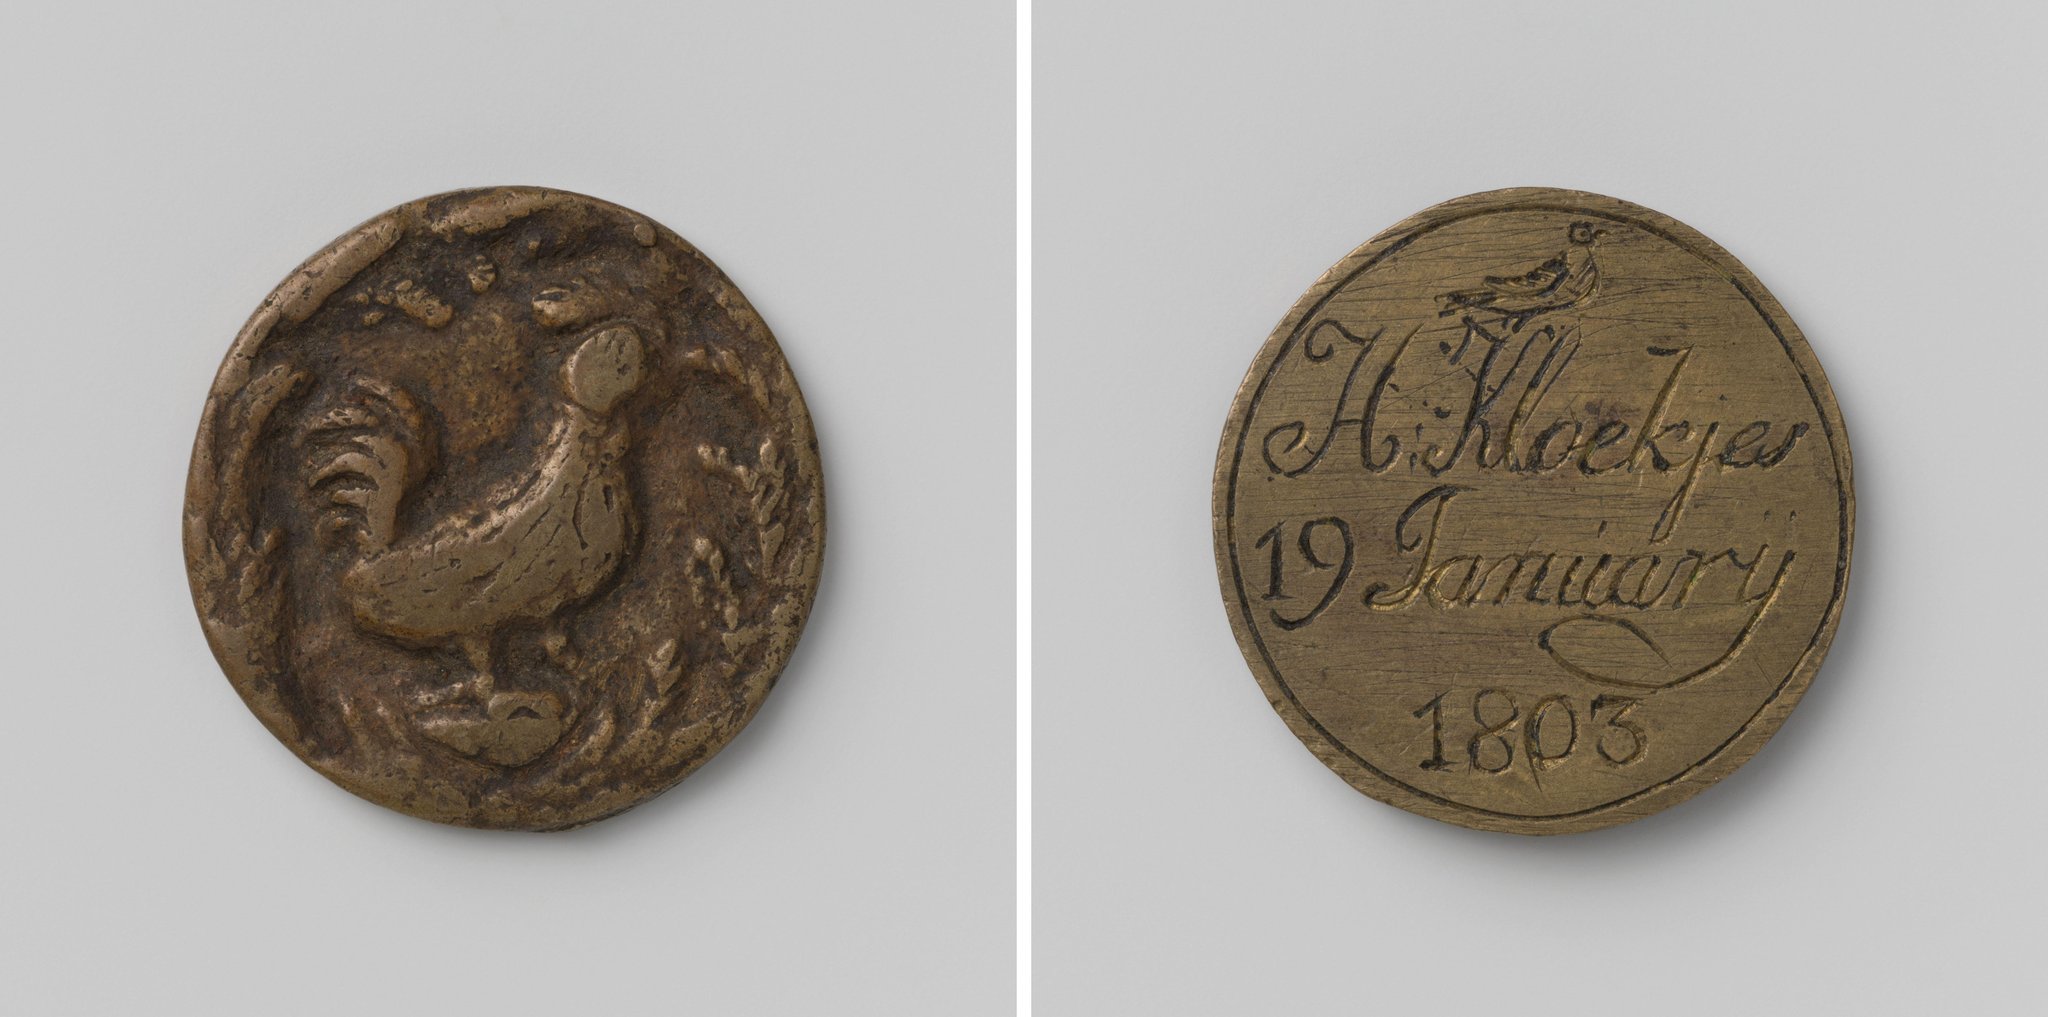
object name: medal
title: Hoender-, konijn- en vogelverkopersgilde van Amsterdam, gildepenning van H. Kloekjes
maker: Anonymous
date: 1803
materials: brass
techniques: casting, engraving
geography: amsterdam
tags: amsterdam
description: Messing penning. Voorzijde: naar rechts gewende haan binnen bladerkrans. Keerzijde: opschrift onder naar rechts gewende vogel